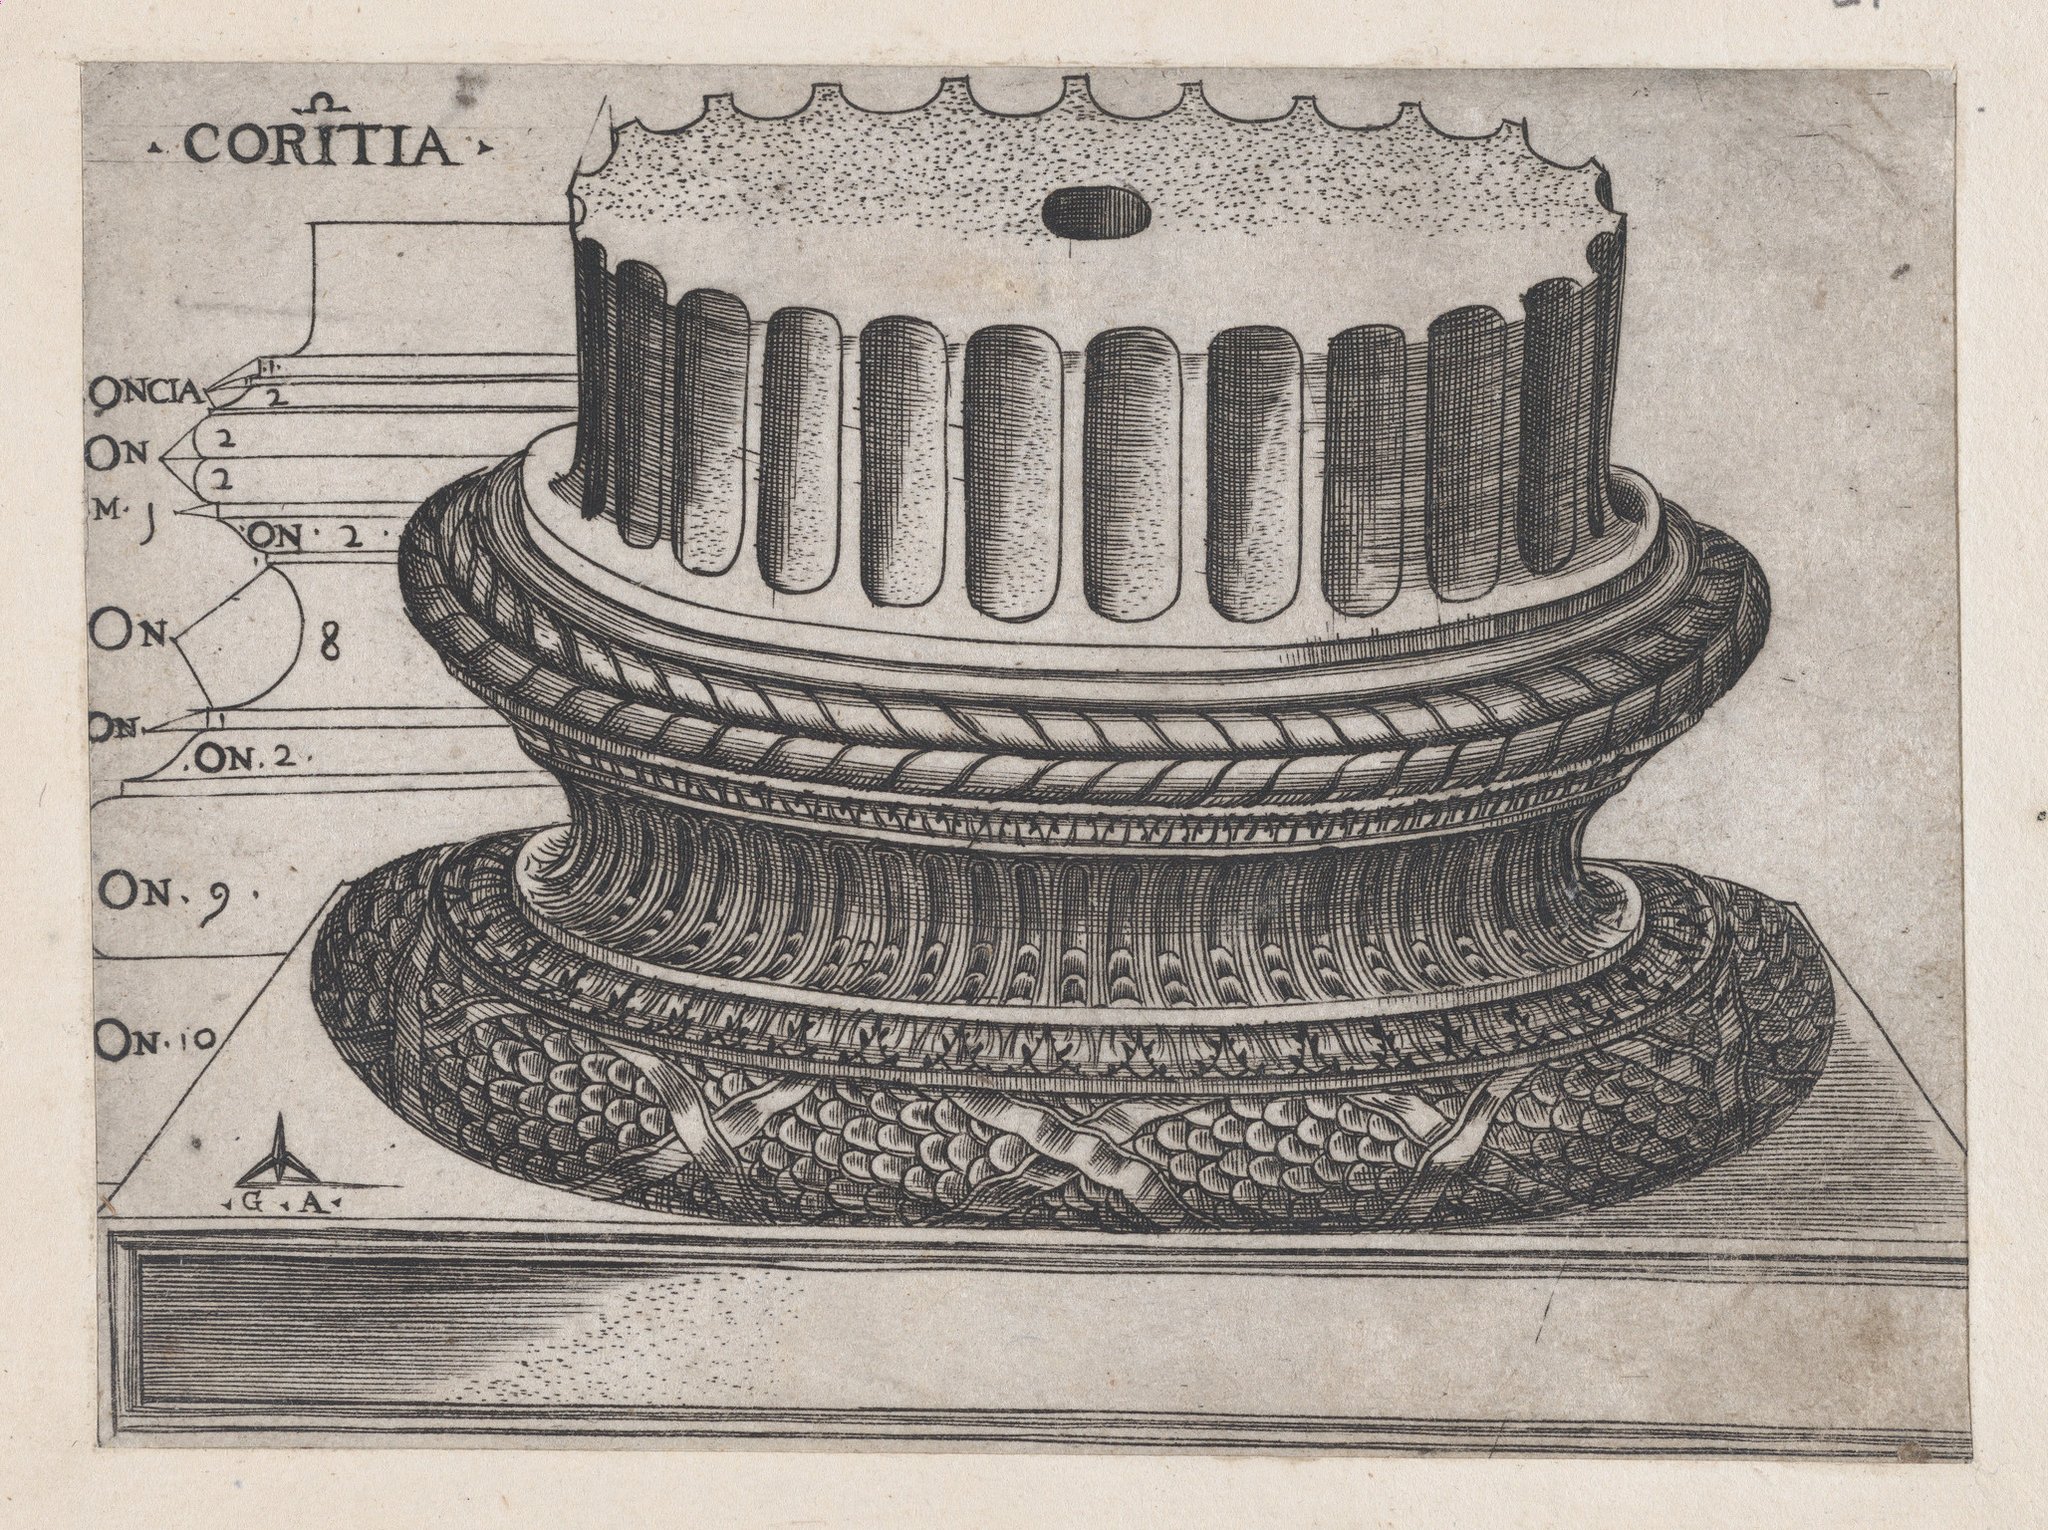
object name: print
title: Corinthian base, from "Speculum Romanae Magnificentiae"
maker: monogrammist g.a. with the caltrop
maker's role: artist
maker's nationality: italian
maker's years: 1535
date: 1537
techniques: engraving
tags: architecture